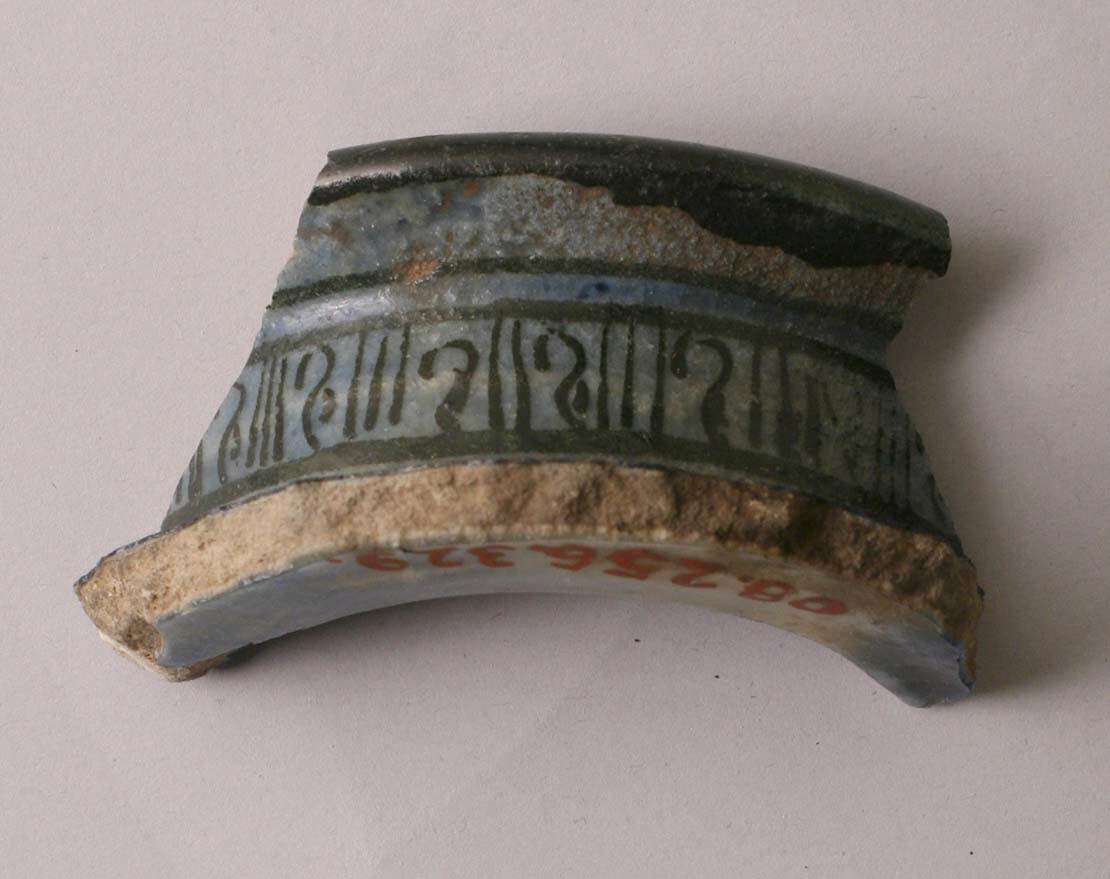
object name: fragment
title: Fragment of Jar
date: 1301-1500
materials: glaze, stonepaste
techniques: painting, underglaze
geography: egypt or syria